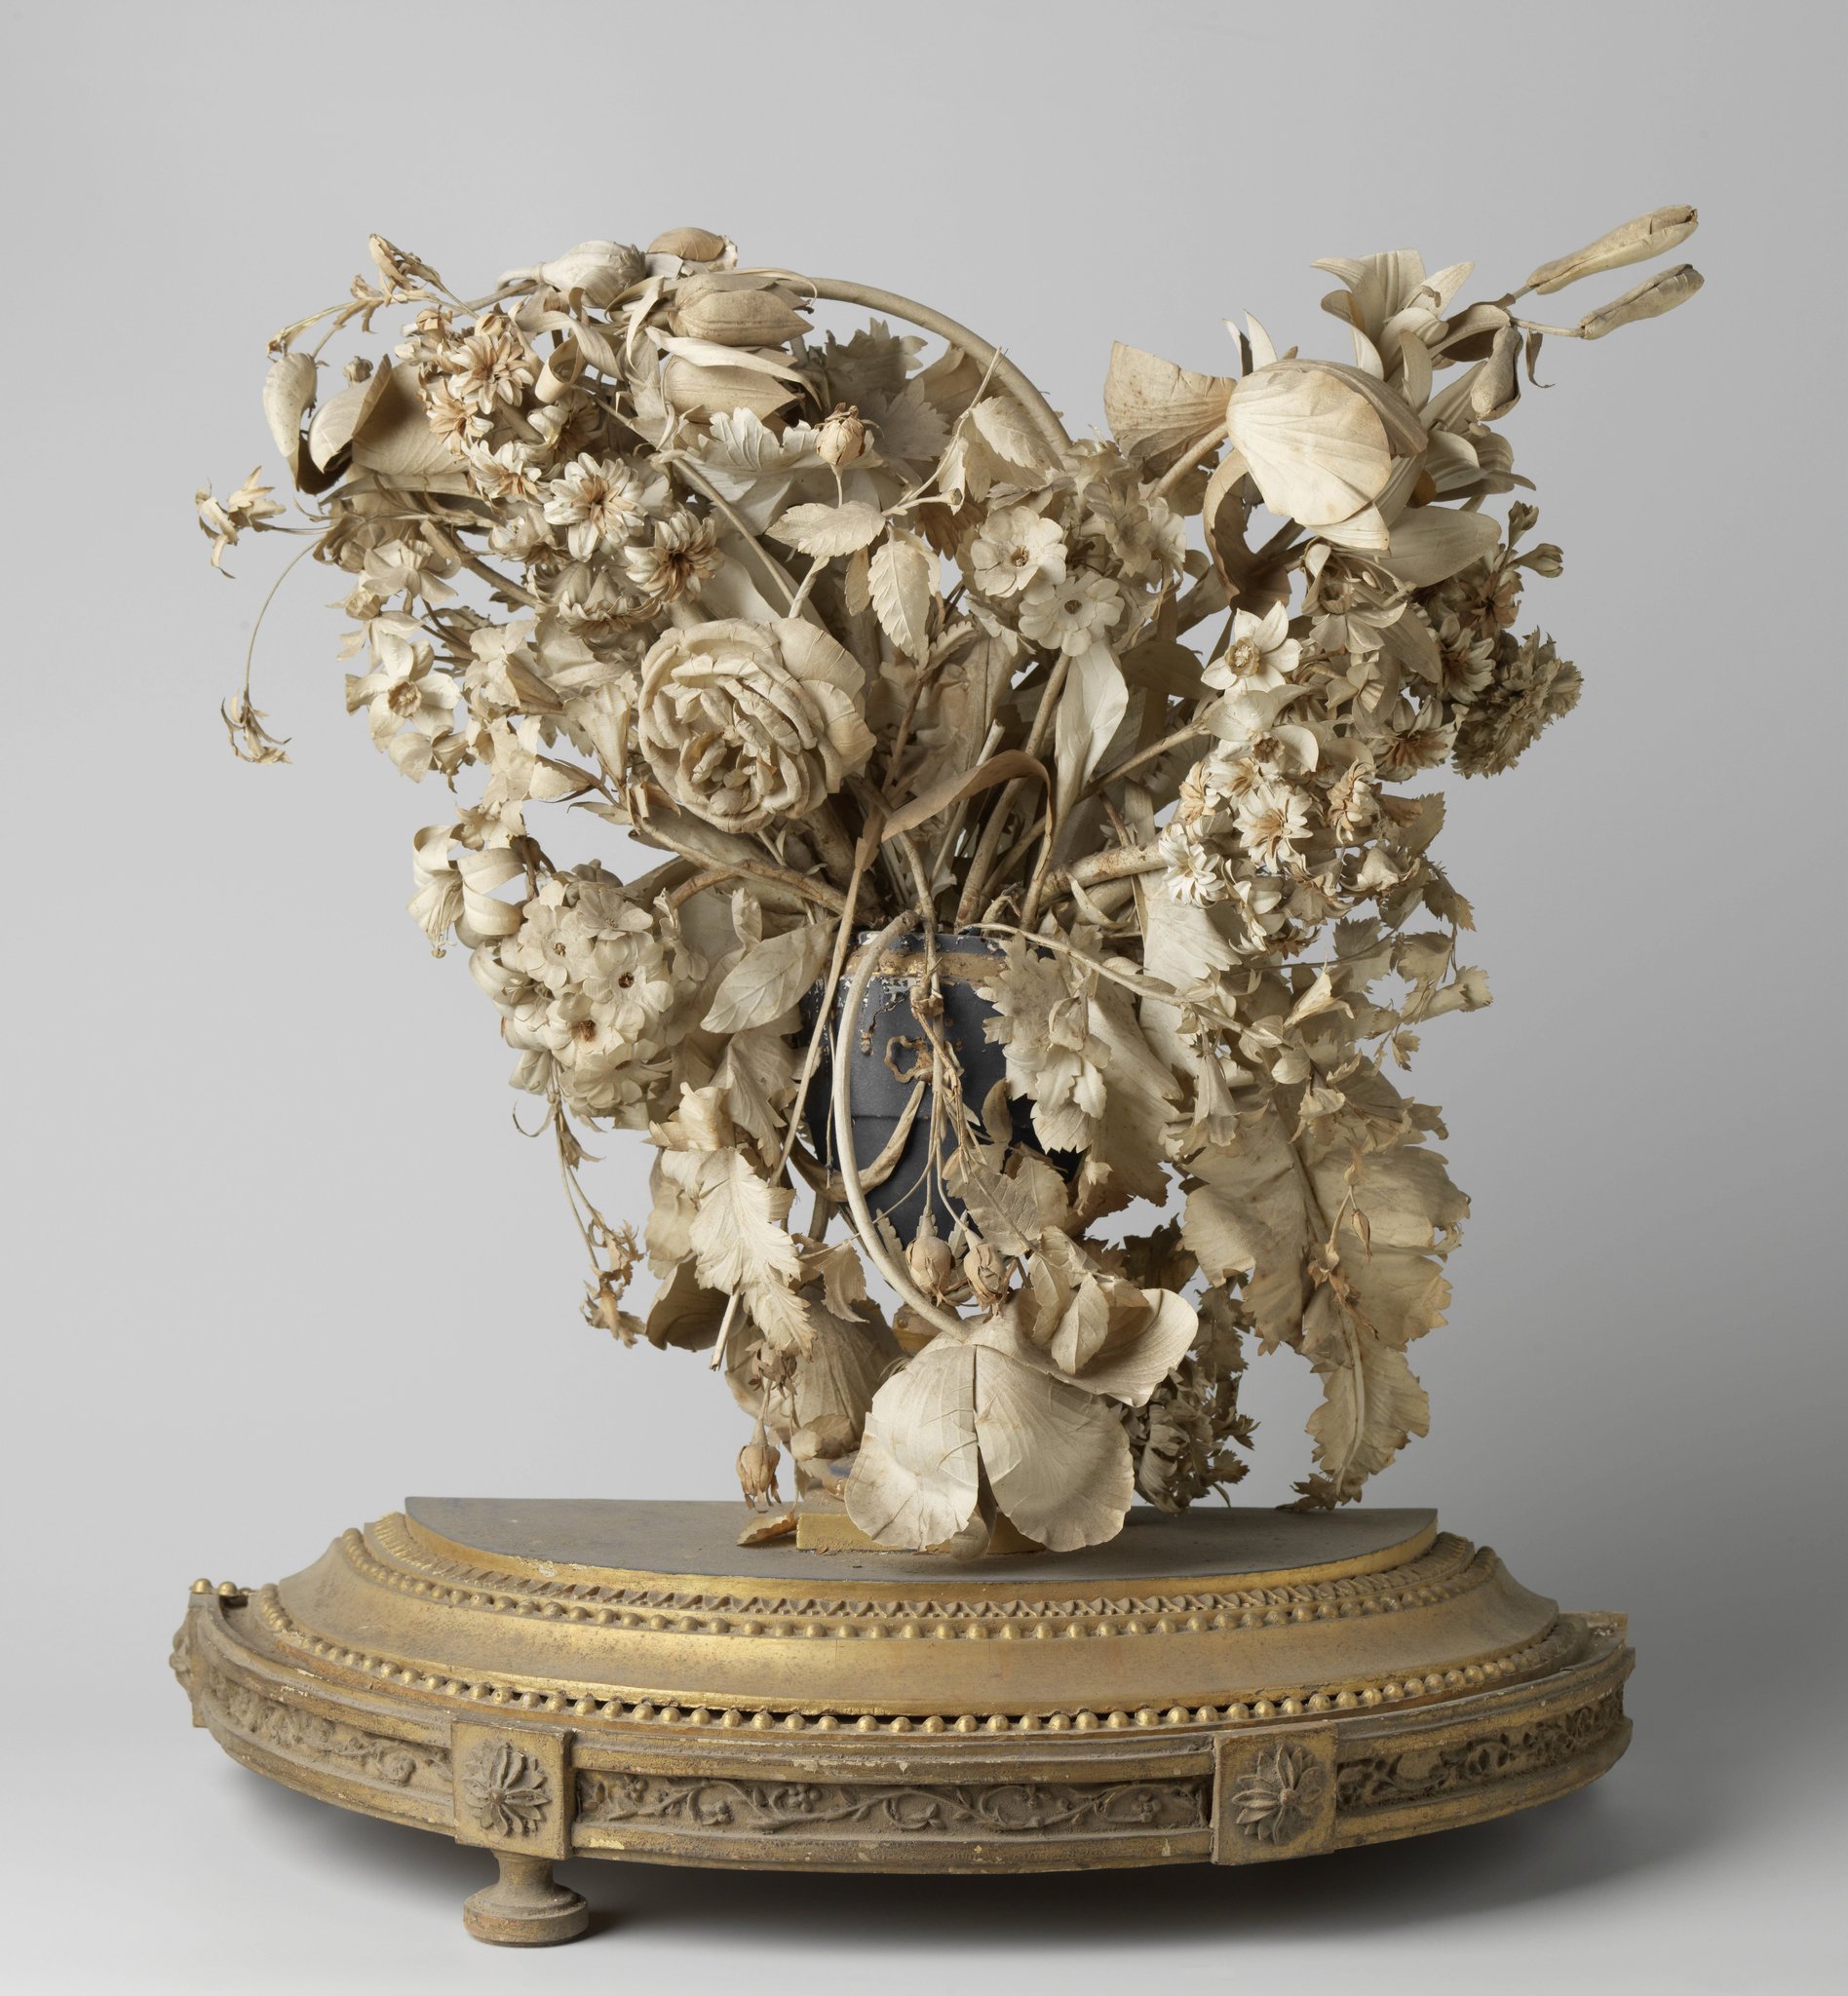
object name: cut paper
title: Bloemenruiker van geknipt wit papier in een vaas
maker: hendrik van irkoven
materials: glass, paper, wood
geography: netherlands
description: Bloemenruiker van geknipt wit papier in een vaas, voorheen onder stolp.